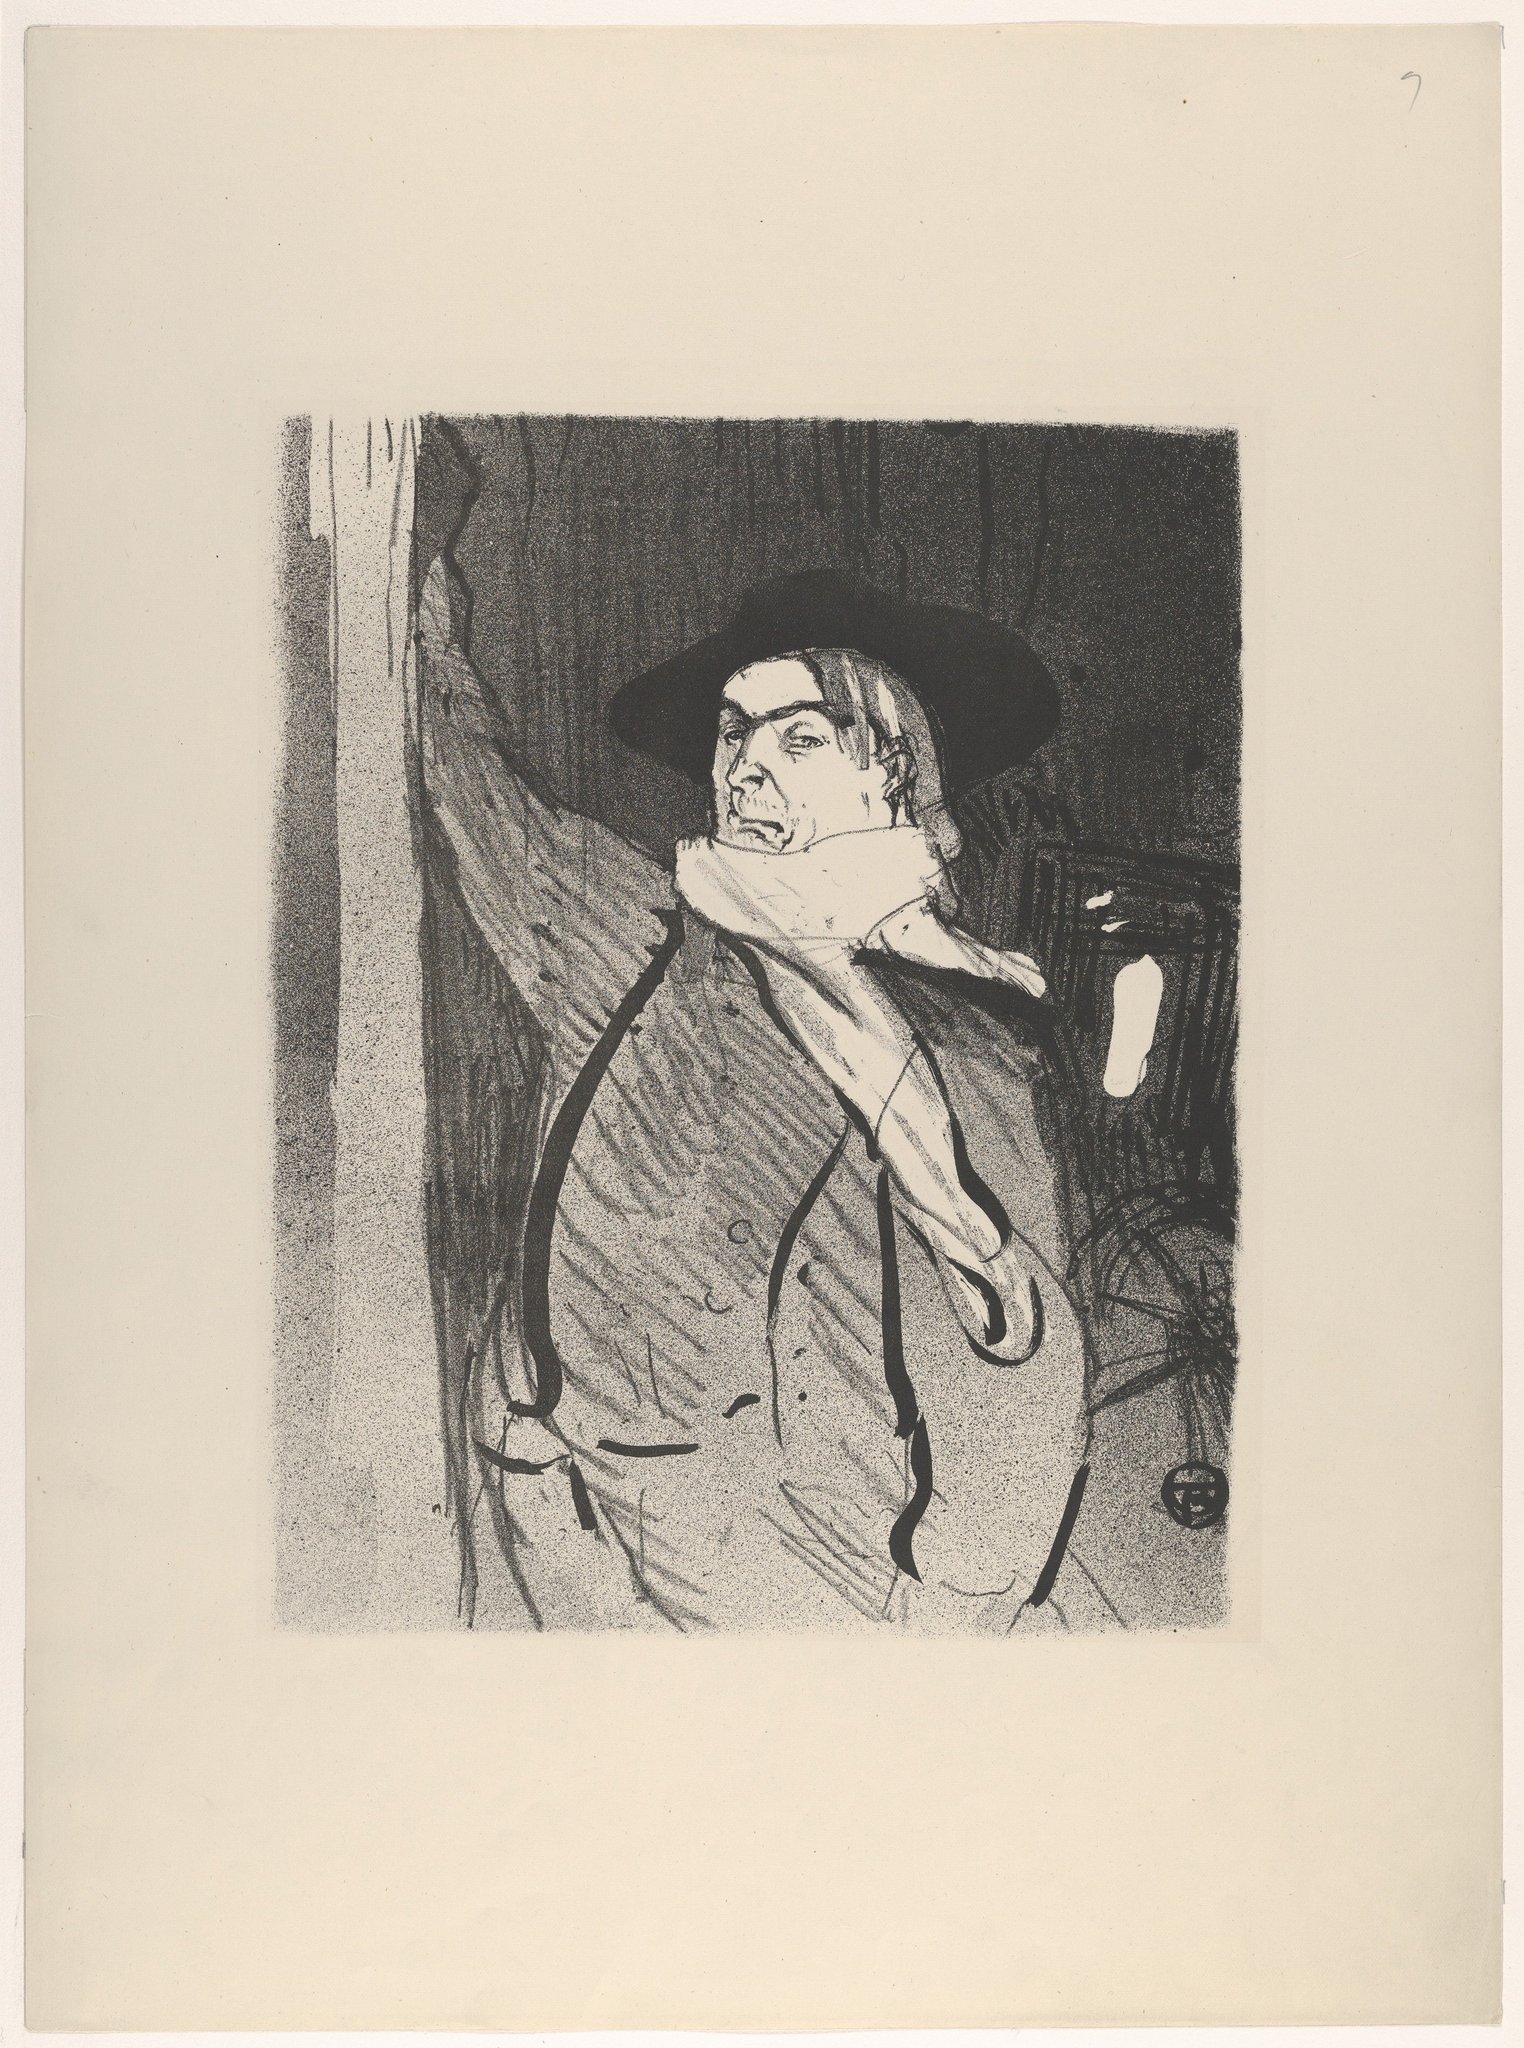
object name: print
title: Aristide Bruant (from Le Café Concert)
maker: henri de toulouse-lautrec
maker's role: artist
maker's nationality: french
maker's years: 1864-1901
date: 1893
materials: crayon, paper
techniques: brush, lithograph, printing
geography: france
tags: men